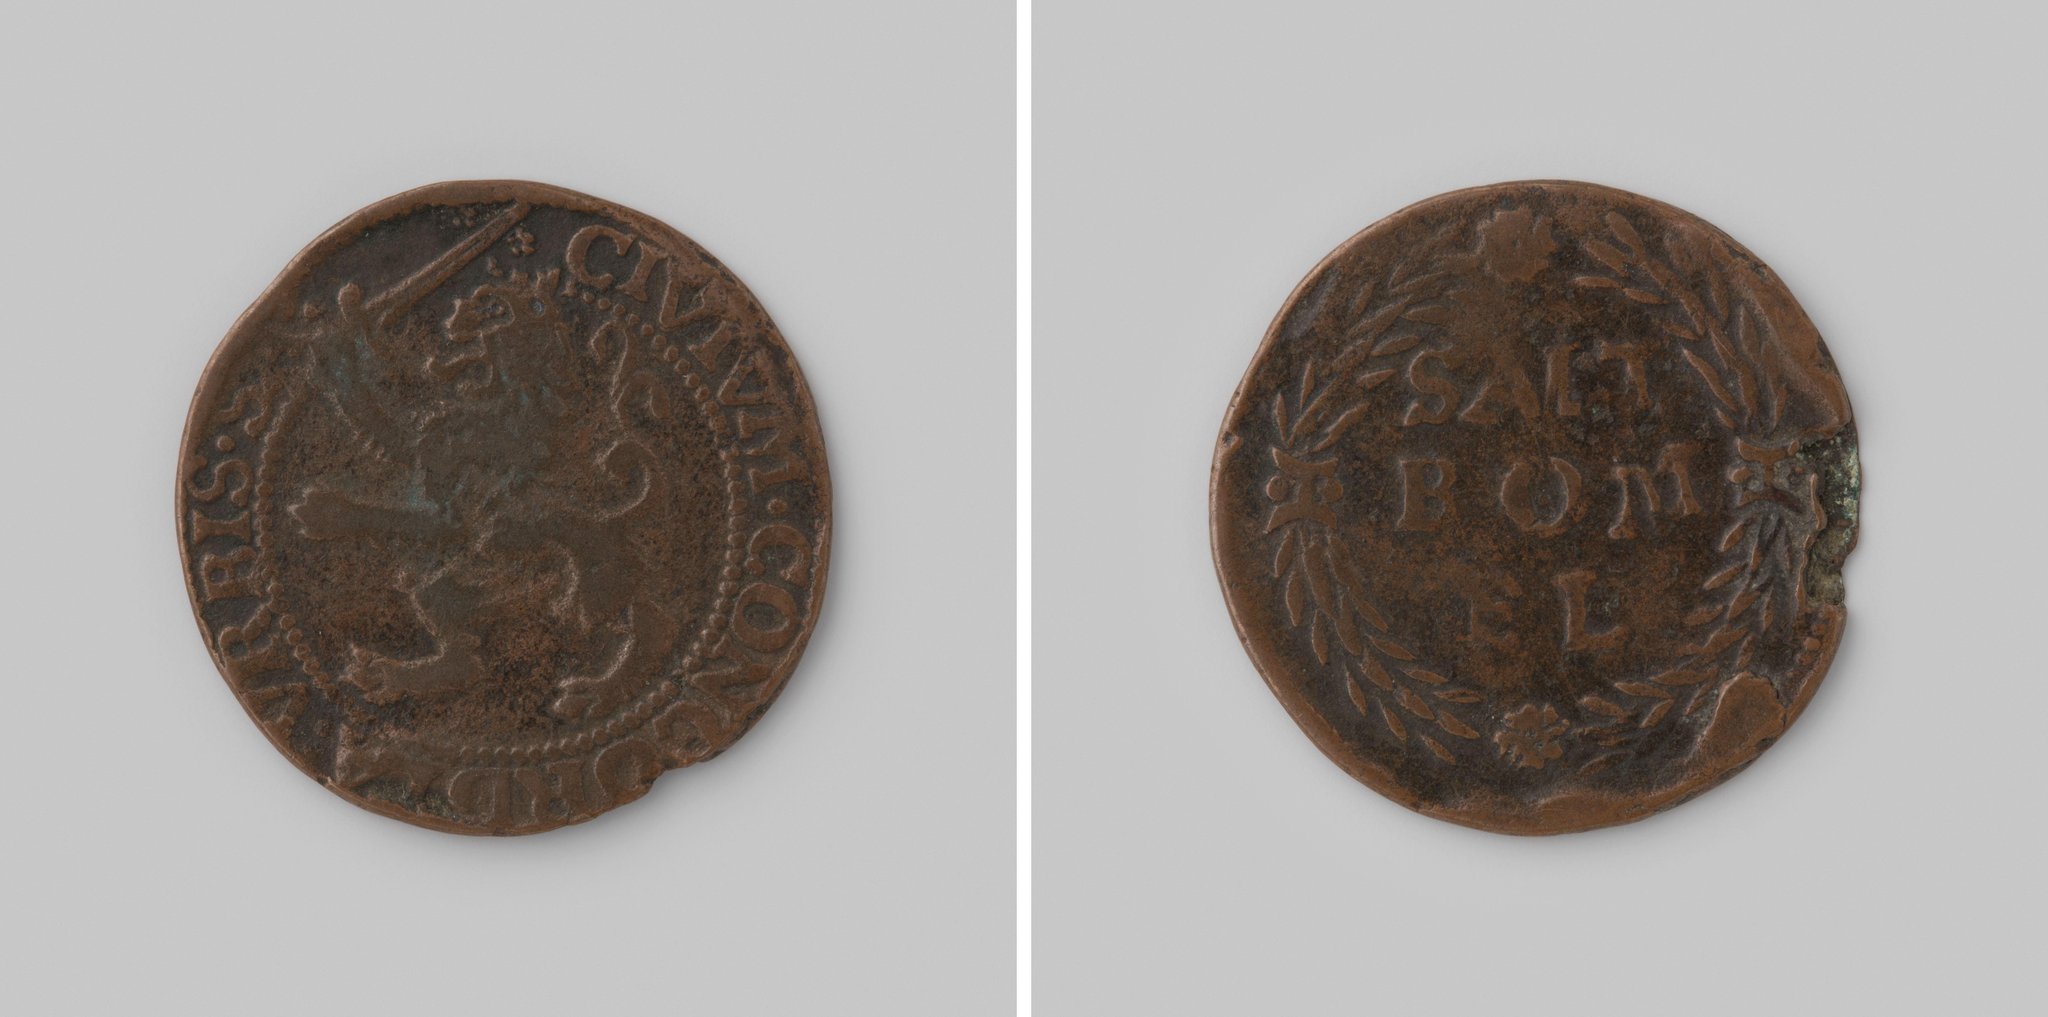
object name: coin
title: Zaltbommelse duit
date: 1591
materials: copper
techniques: striking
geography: zaltbommel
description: Koperen munt. Voorzijde: klimmende leeuw met zwaard naar links. Keerzijde: in lauwerkrans opschrift: stadsnaam in drie regels.